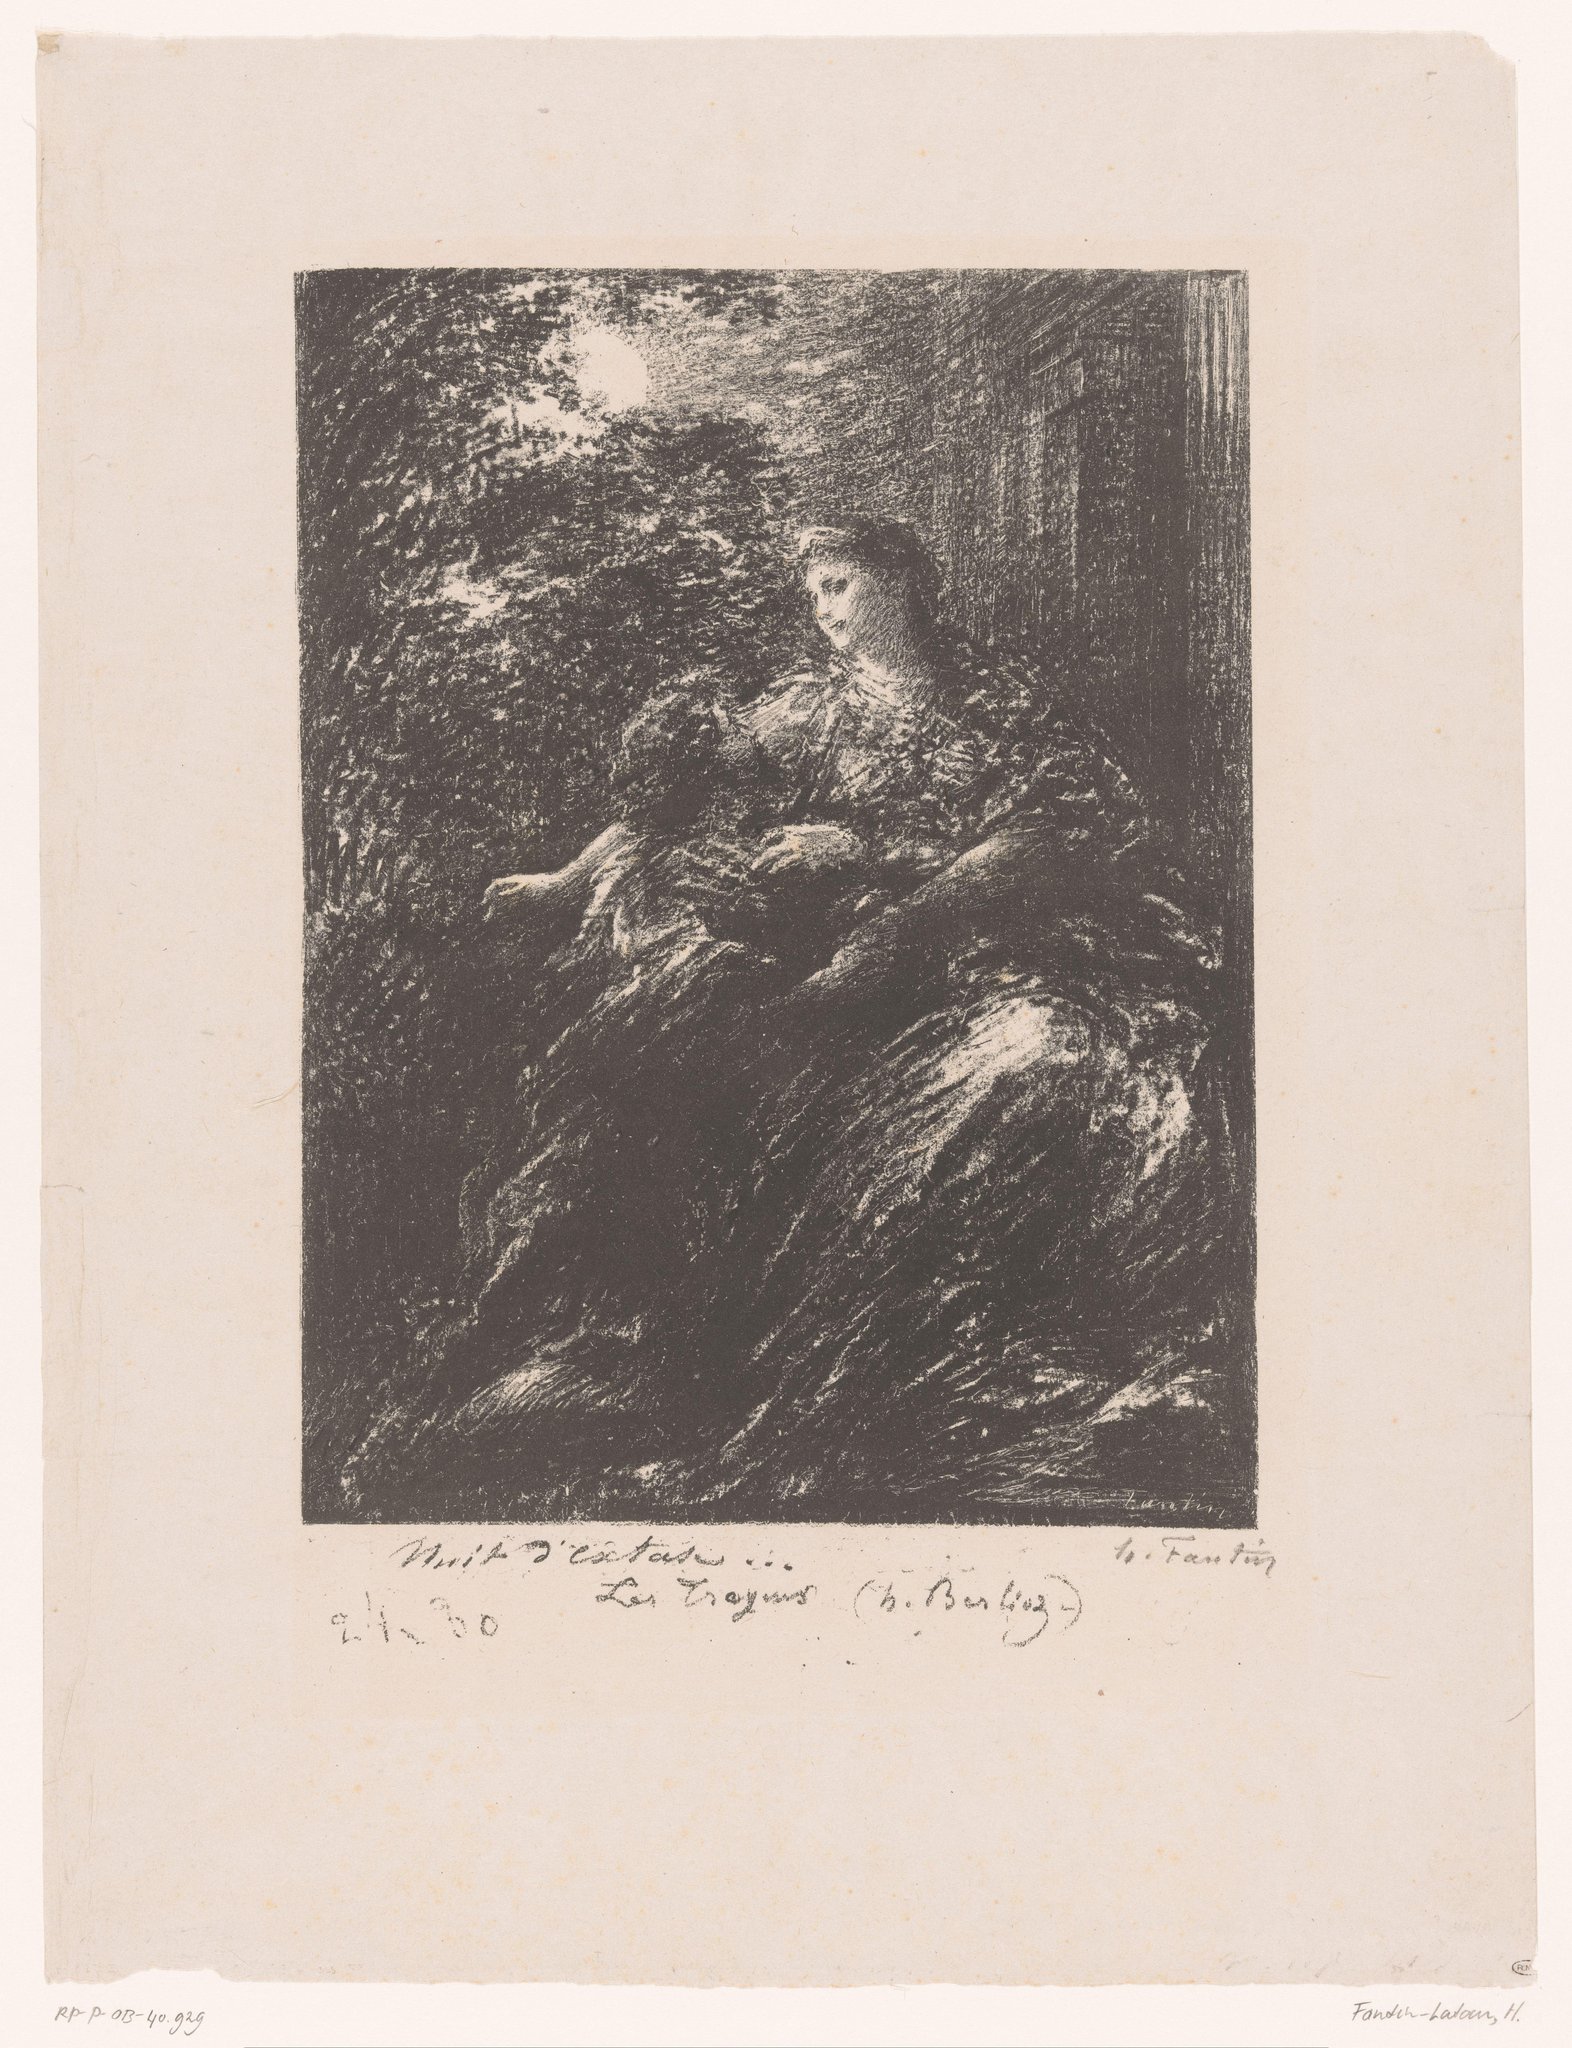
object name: print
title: Duo des Troyens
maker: henri fantin-latour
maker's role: draughtsman, print maker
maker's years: 1836-1904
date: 1894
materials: paper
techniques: lithography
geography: paris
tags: (story of) dido - love-affairs, love-affairs of aeneas, lovers' meeting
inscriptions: collector's mark: Lugt 2229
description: Prent gebruikt voor: Gesellschaft für vervielfältigende Kunst de Vienne, 1894.